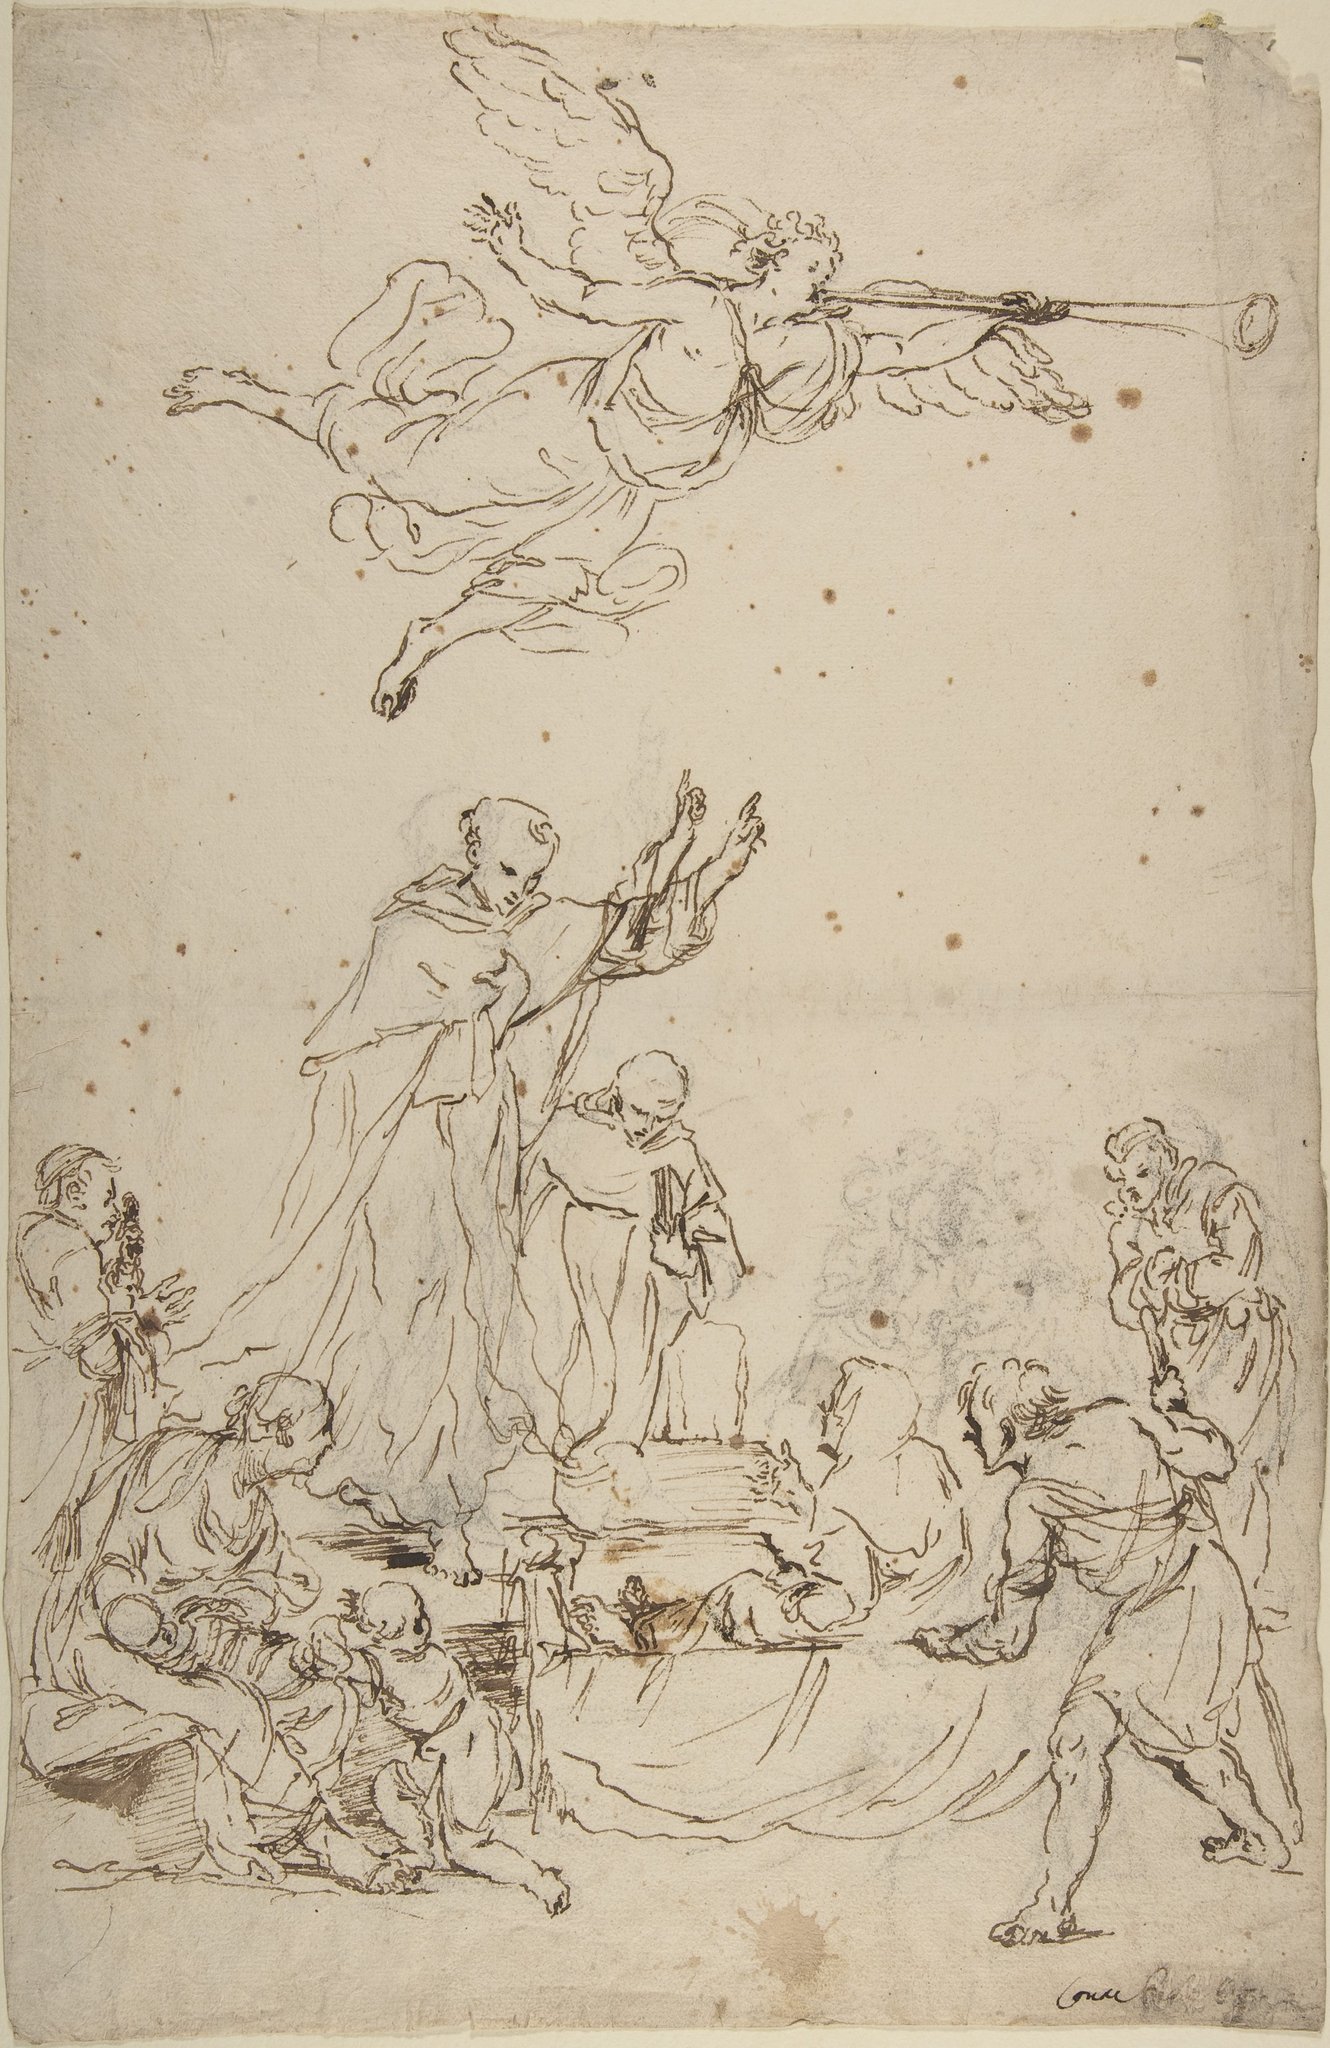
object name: drawing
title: The Rising of Nazareth (?)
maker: anonymous, italian, 18th century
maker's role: artist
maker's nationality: italian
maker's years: 1700-1800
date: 1701-1800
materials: ink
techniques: pen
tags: children,men,women,angels